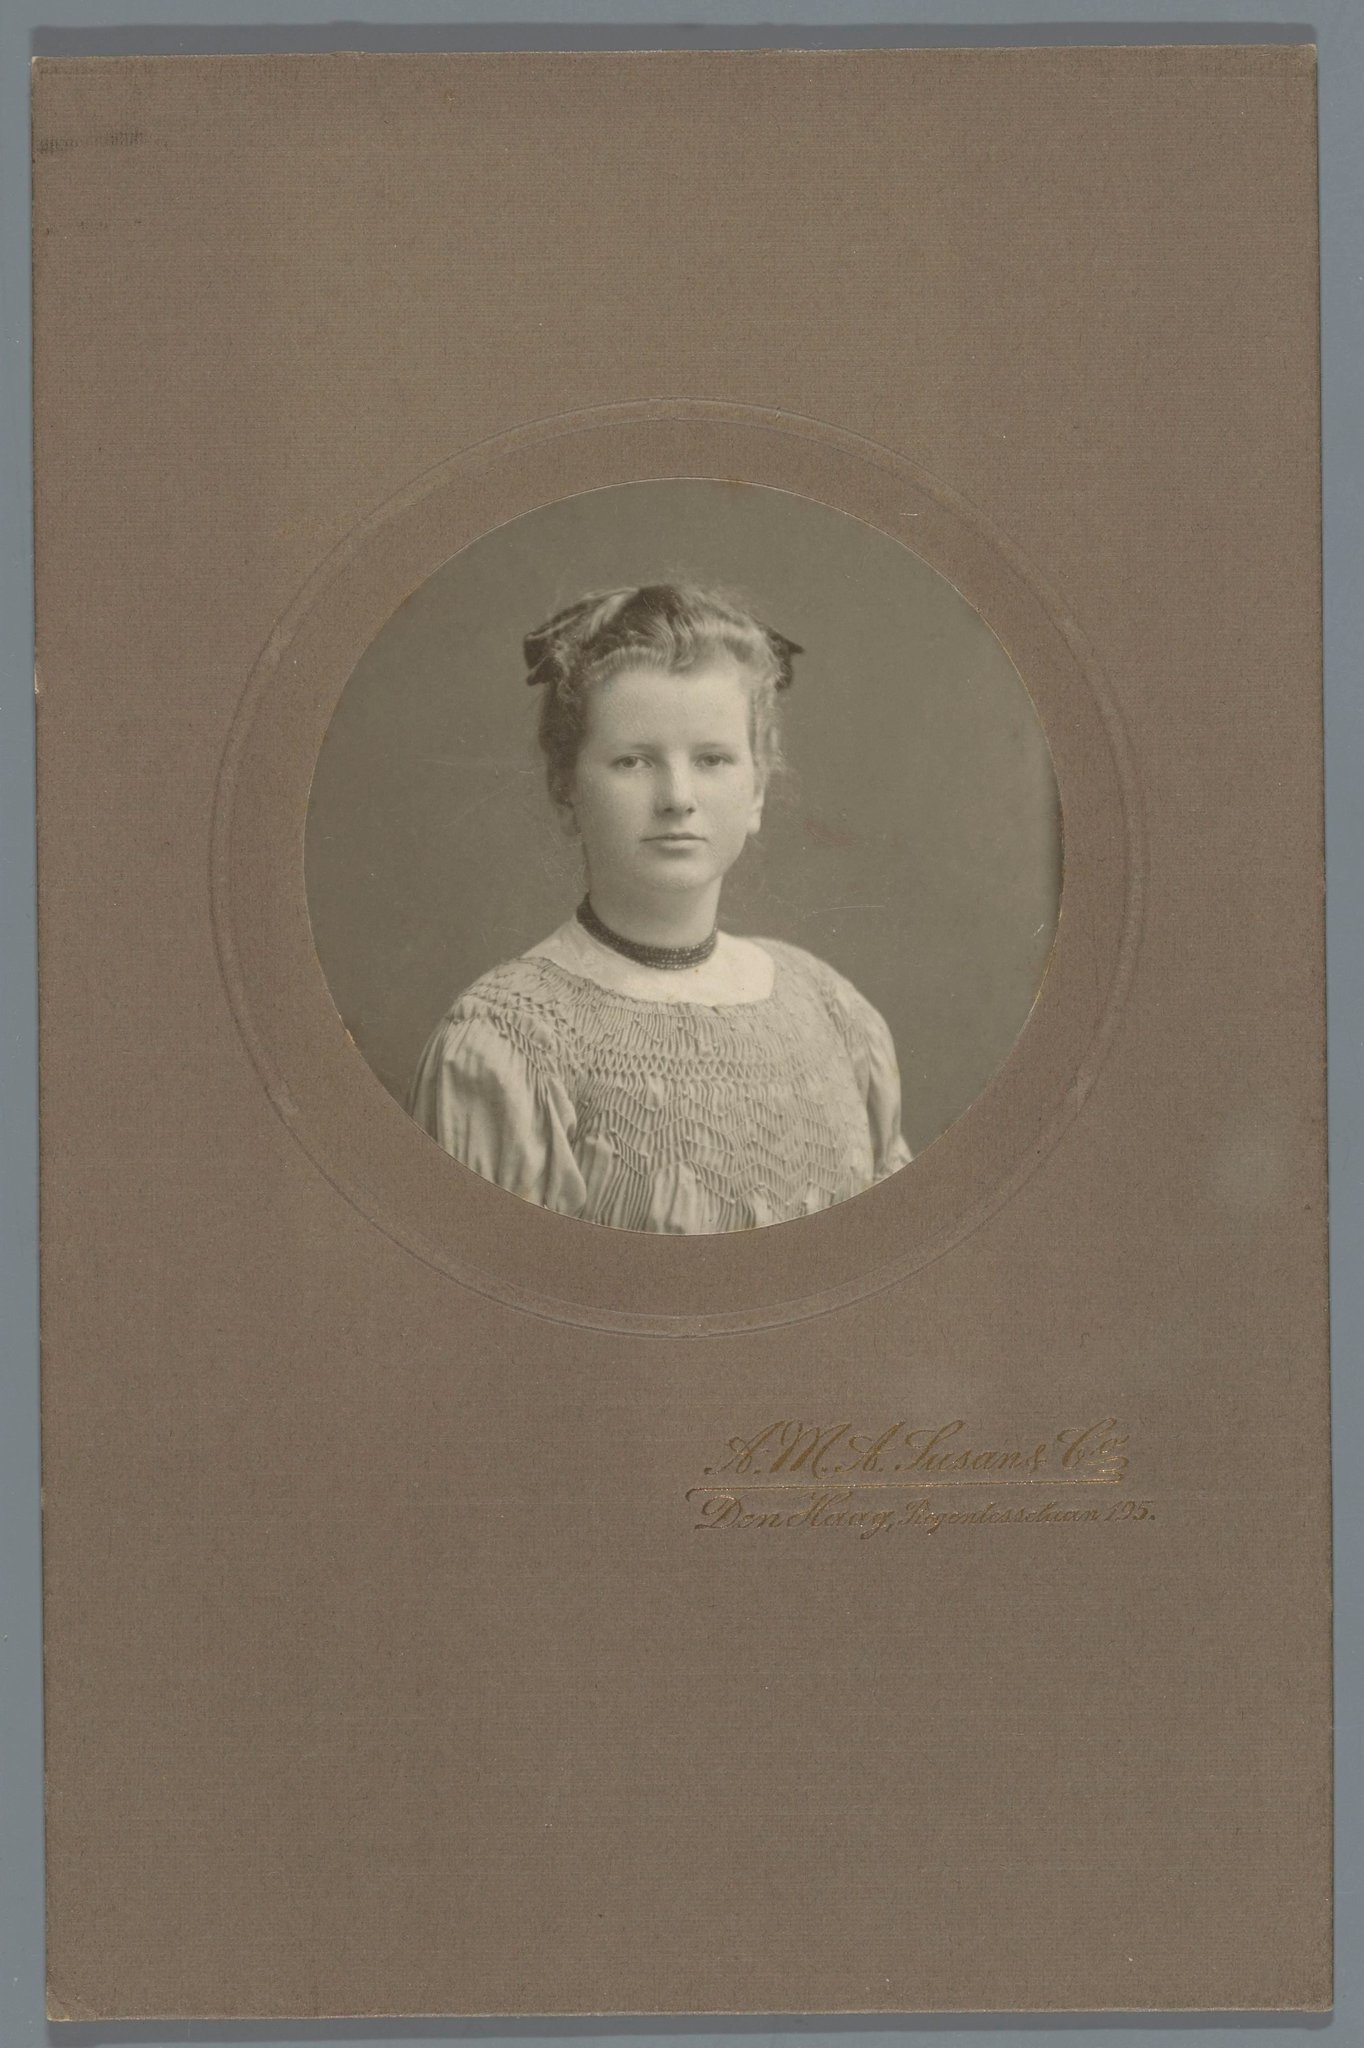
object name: photograph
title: Portret van een onbekende vrouw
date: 1900-1915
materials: cardboard, photographic support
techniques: gelatin silver print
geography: the hague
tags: adult woman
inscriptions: inscription: ‘Fotografische Ateliers (...) Rotterdam’